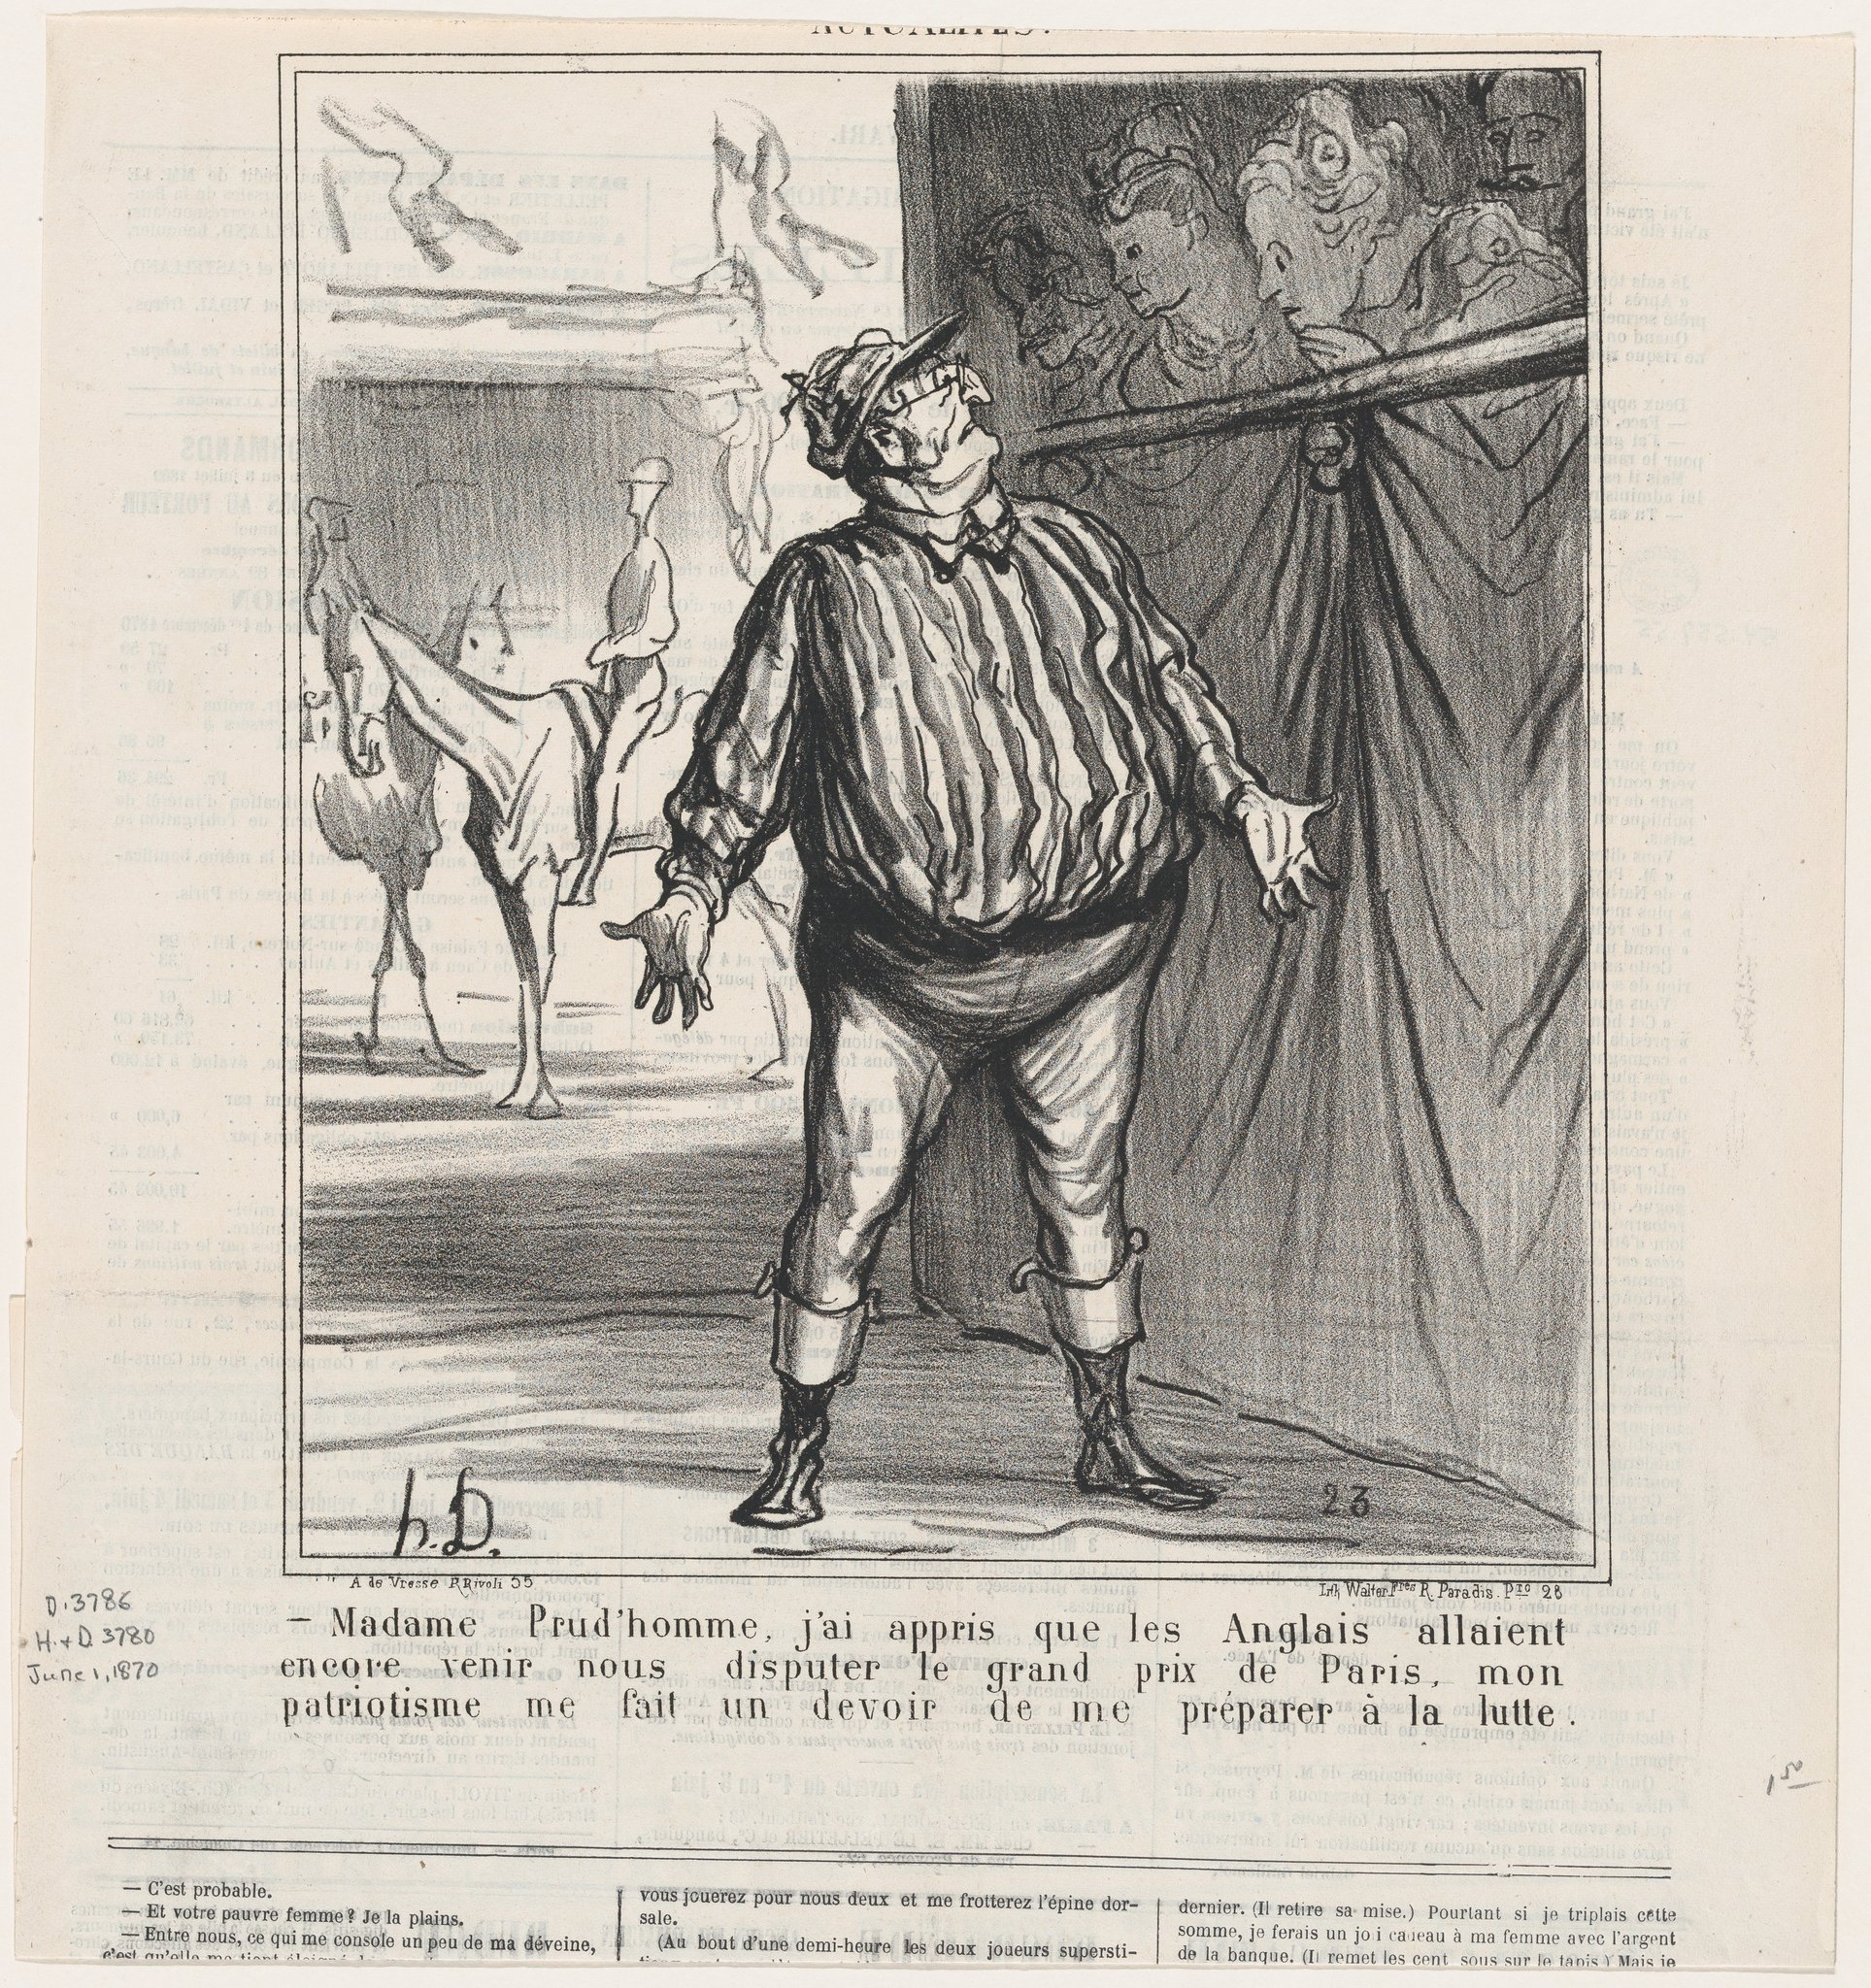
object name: print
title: Madame Prudhomme, I have learned that the English are going to challenge us in the Paris Grand Prix. My patriotism makes it my duty to prepare for this struggle, from 'News of the day,' published in Le Charivari, June 1, 1870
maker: honoré daumier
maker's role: artist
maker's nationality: french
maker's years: 1808-1879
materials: paper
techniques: lithograph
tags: satire,men,women,horses